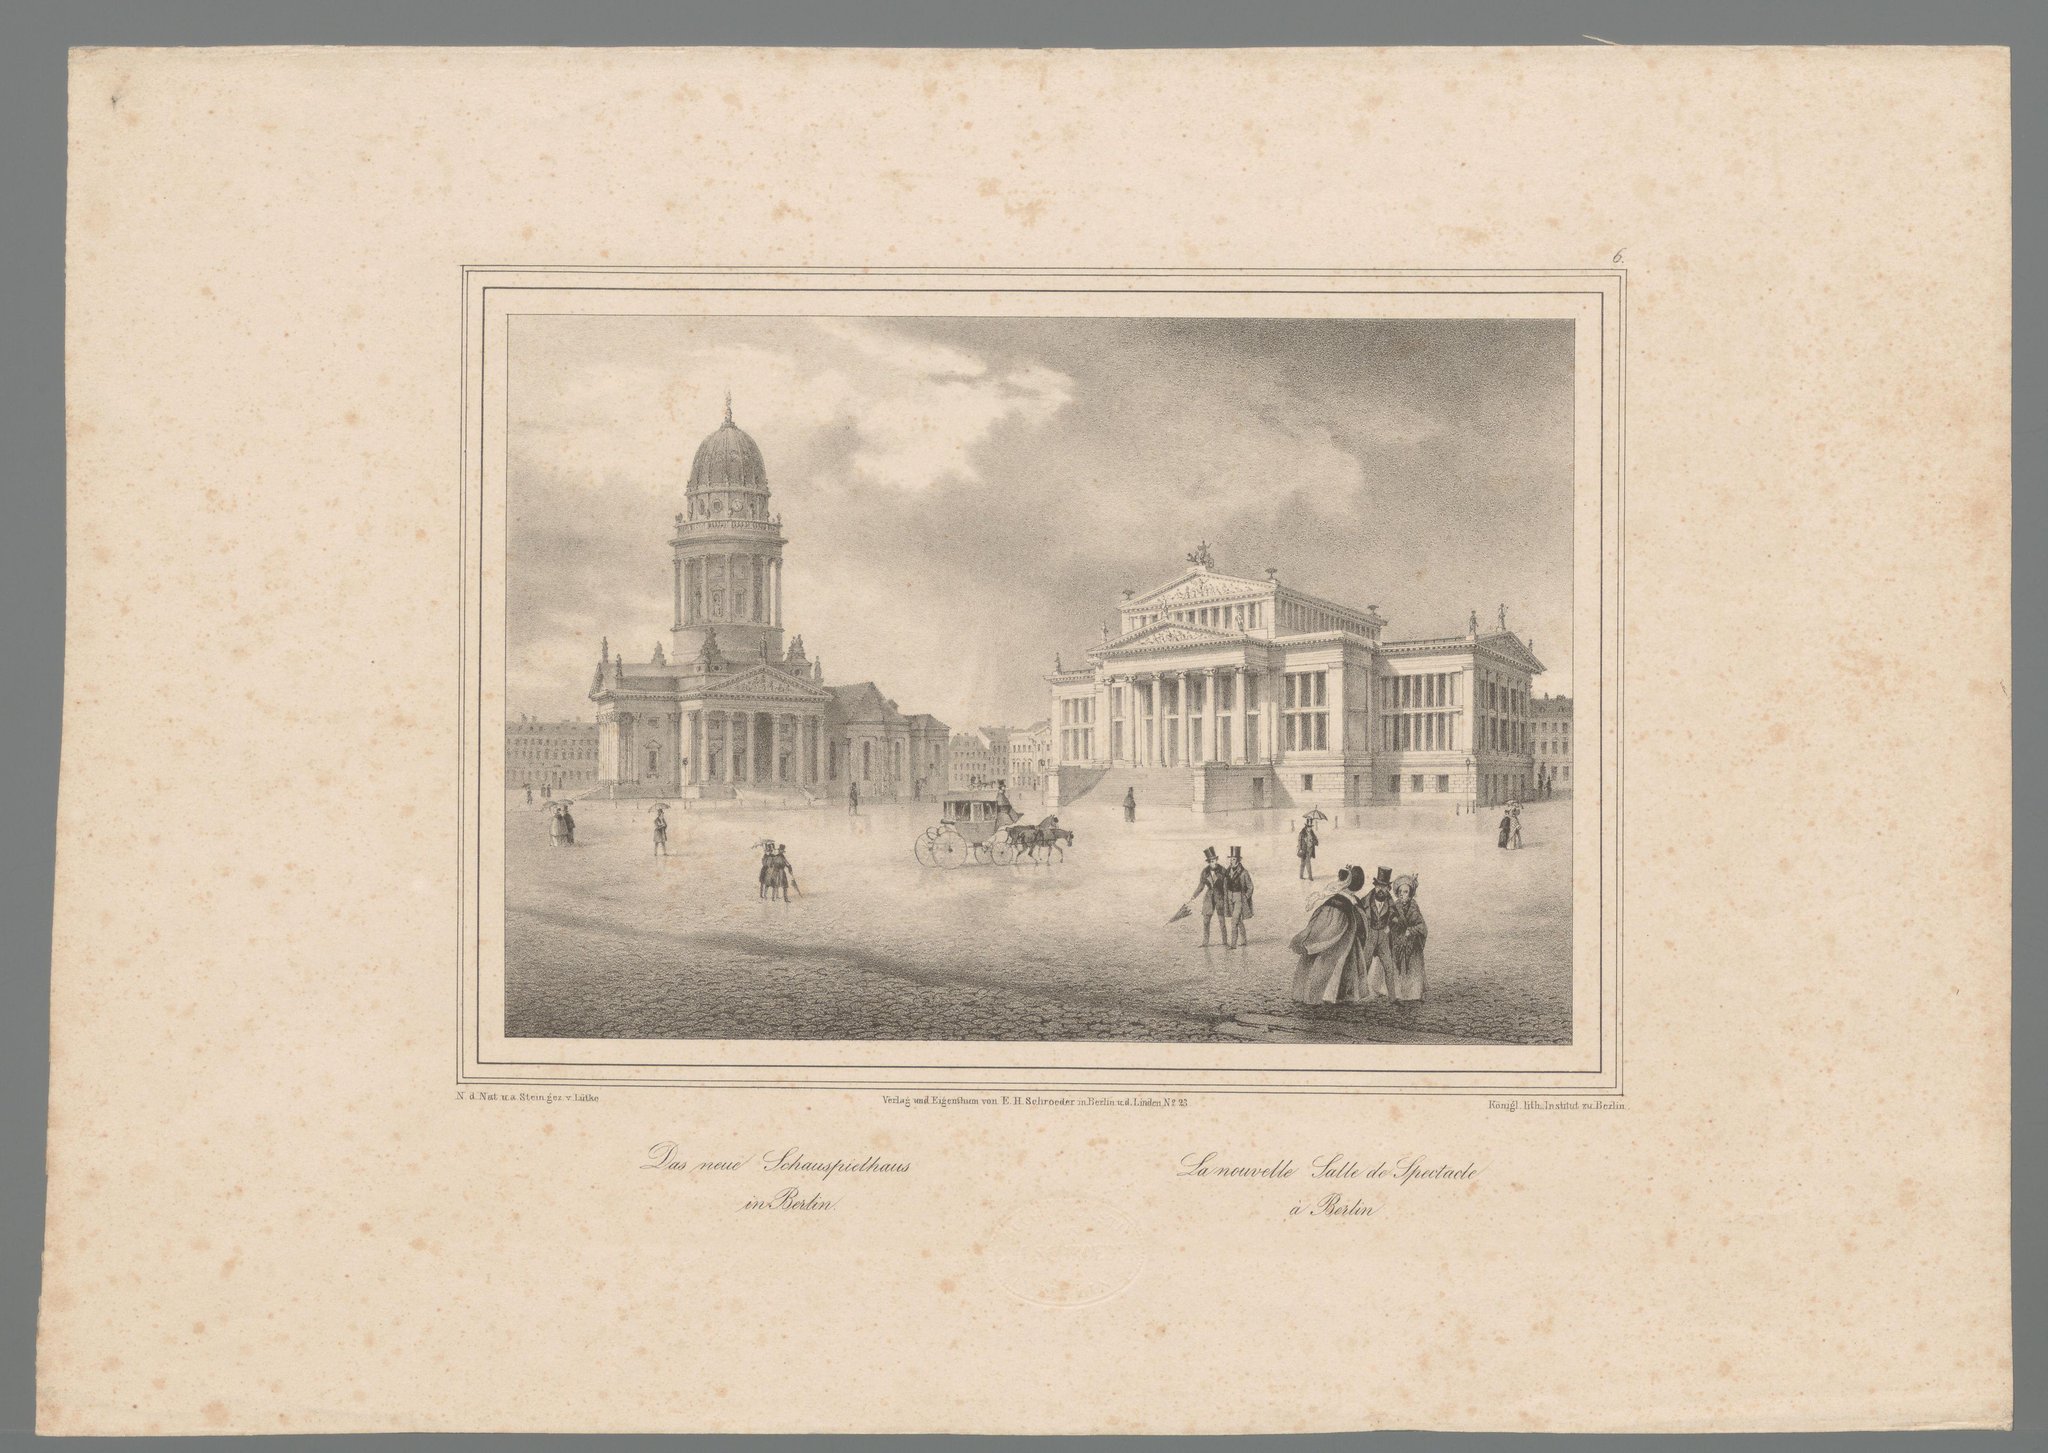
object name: print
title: Landschappen en stadsgezichten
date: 1840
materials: paper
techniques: lithograph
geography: berlin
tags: city-view in general; 'veduta', theatre (building)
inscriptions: collector's mark: Lugt 2228, check stamp: ‘Buch u. Kunsth. von E.H. Schroeder in Berlin’